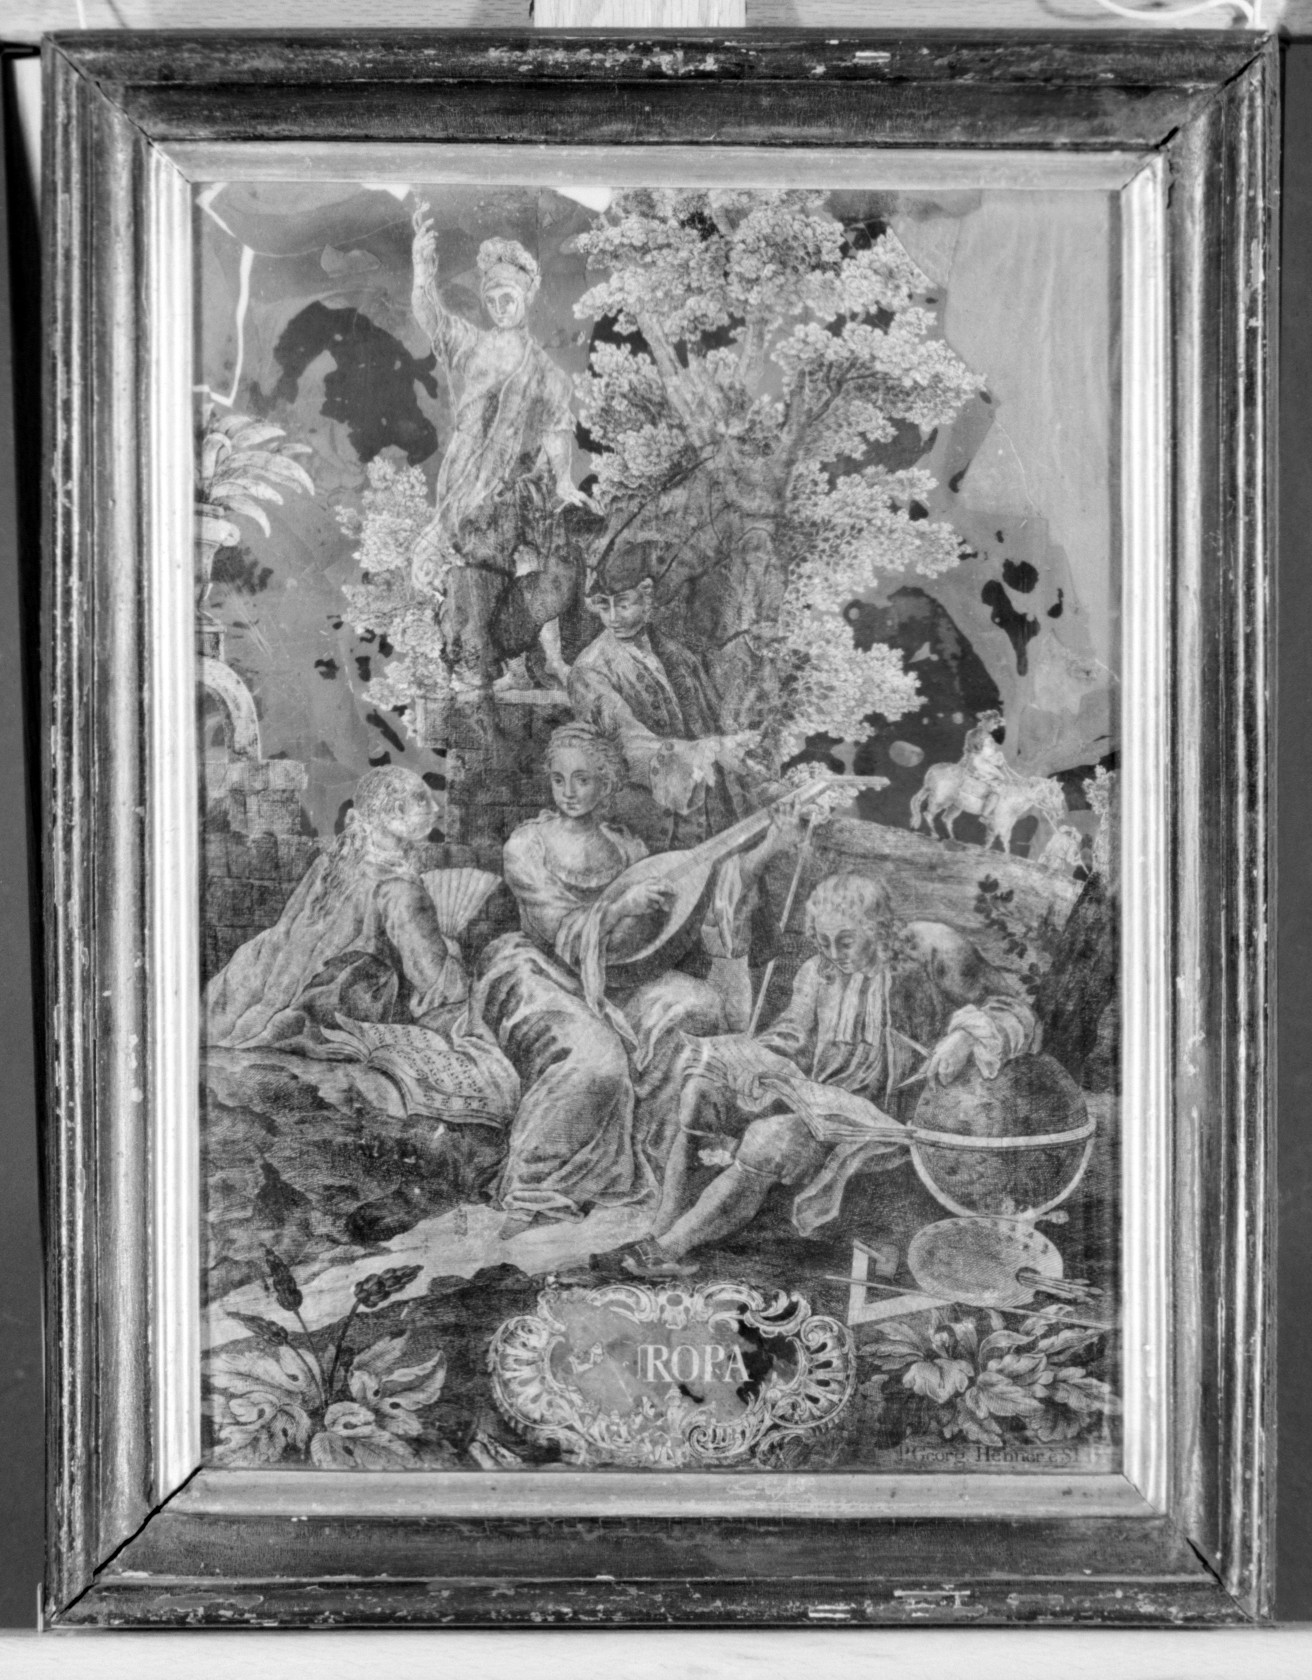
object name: panel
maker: georg henner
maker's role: artist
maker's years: 1727-1827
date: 1777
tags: musical instruments,women,trees